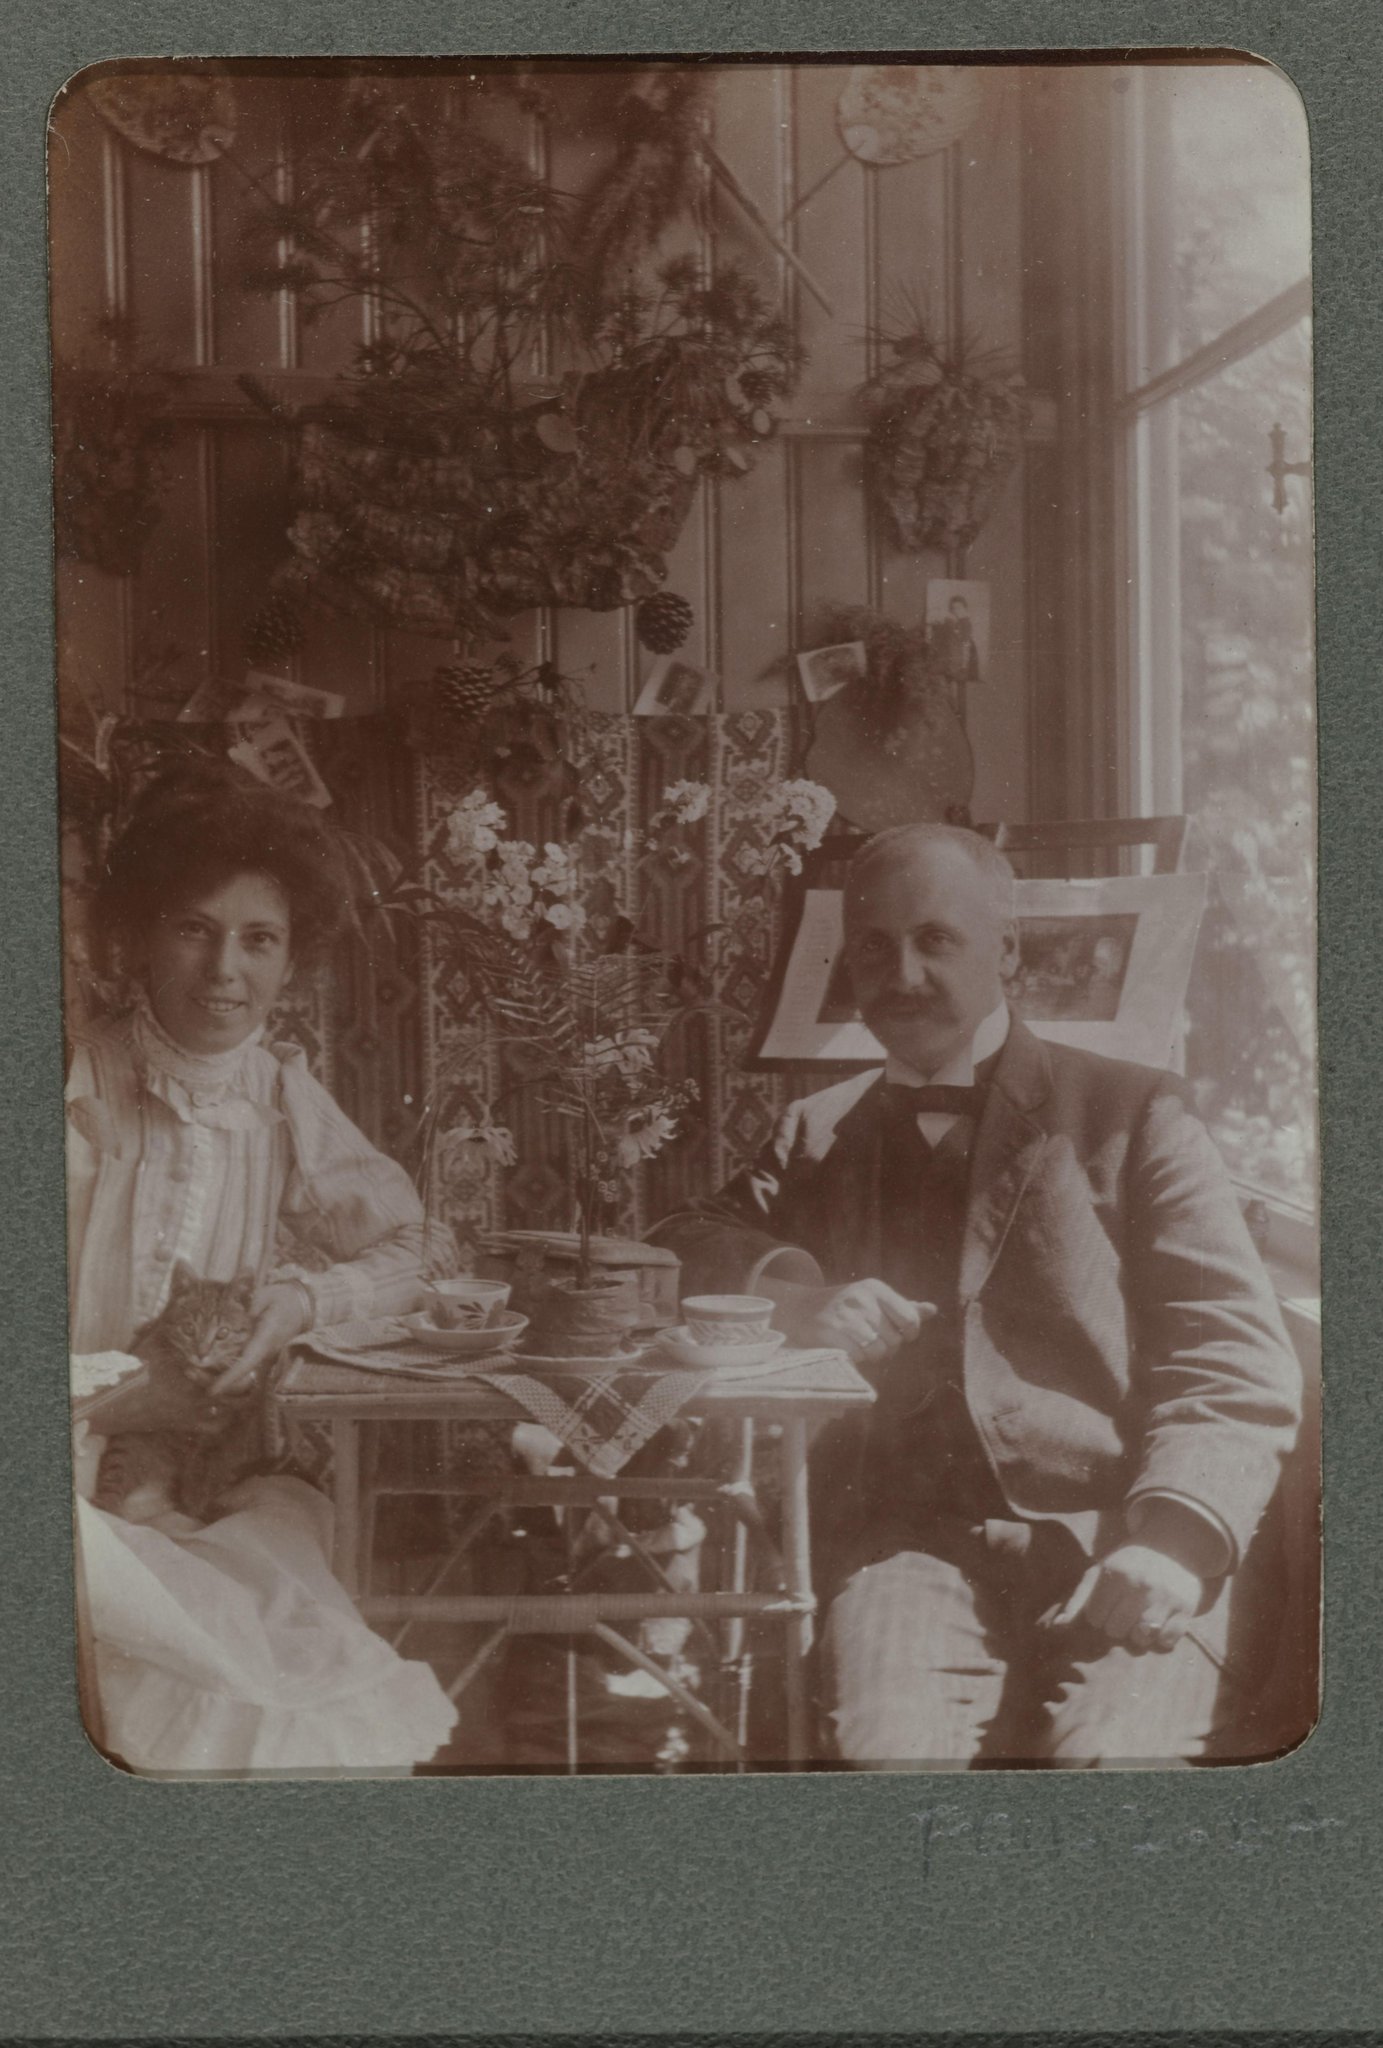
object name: album leaf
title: Portret van een man en vrouw, zittend in een serre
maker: christiaan otto roelofs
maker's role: fotograaf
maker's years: 1882-1970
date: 1900-1915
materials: photographic support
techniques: gelatin silver print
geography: netherlands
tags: adult woman, adult man, historical persons